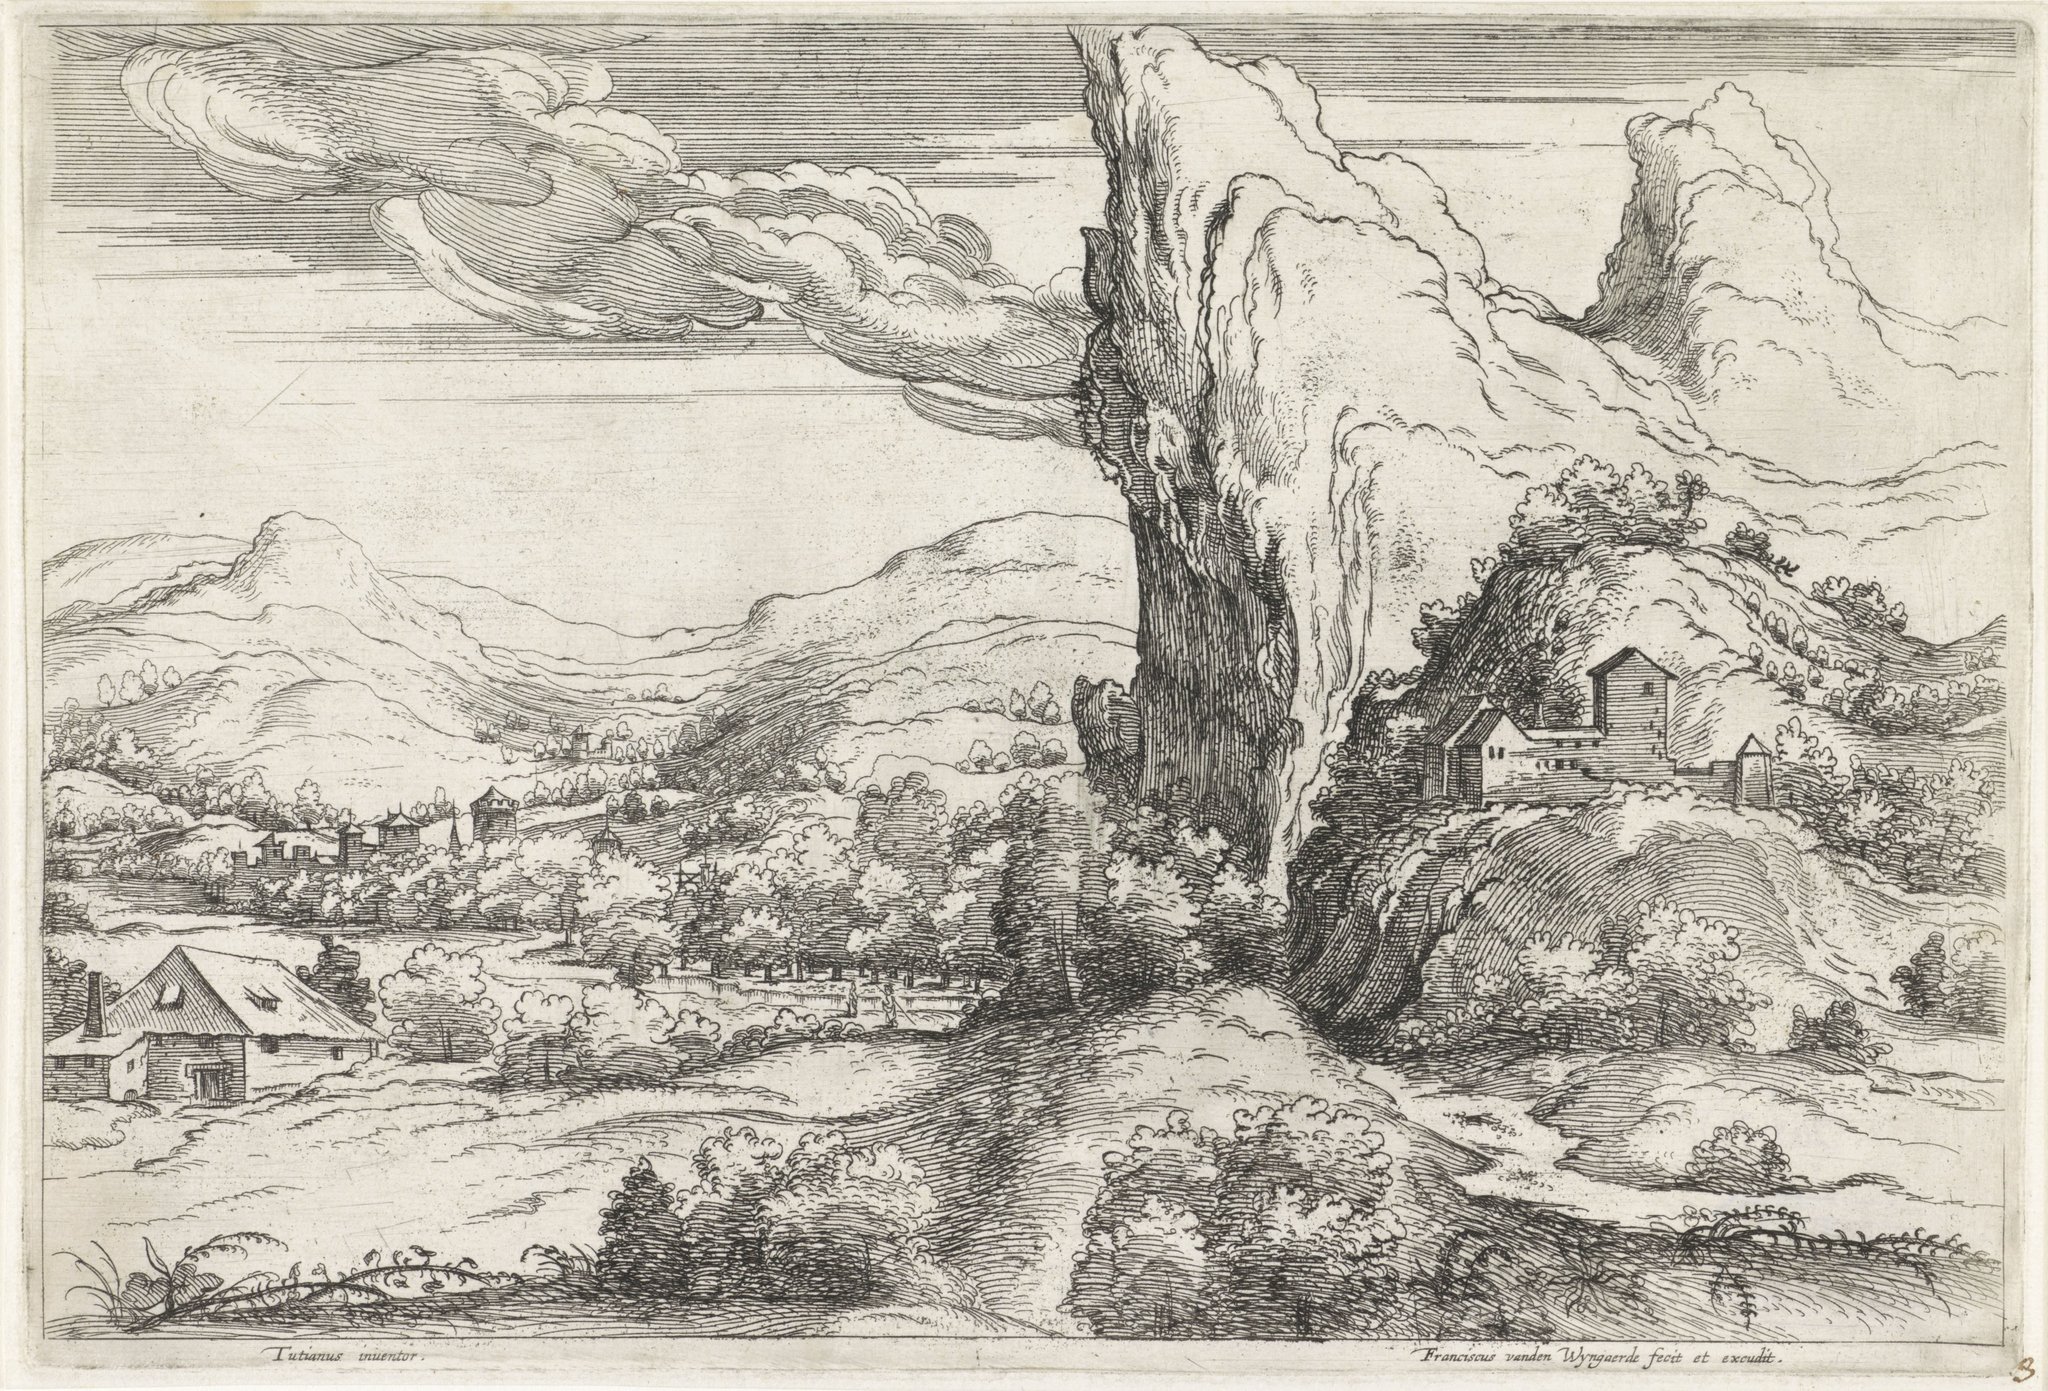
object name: print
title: Berglandschap met hoge kliffen en een huisje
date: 1636-1679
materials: paper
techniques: etching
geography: antwerp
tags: inland cliff face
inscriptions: number: ‘3’, collector's mark: Lugt 11